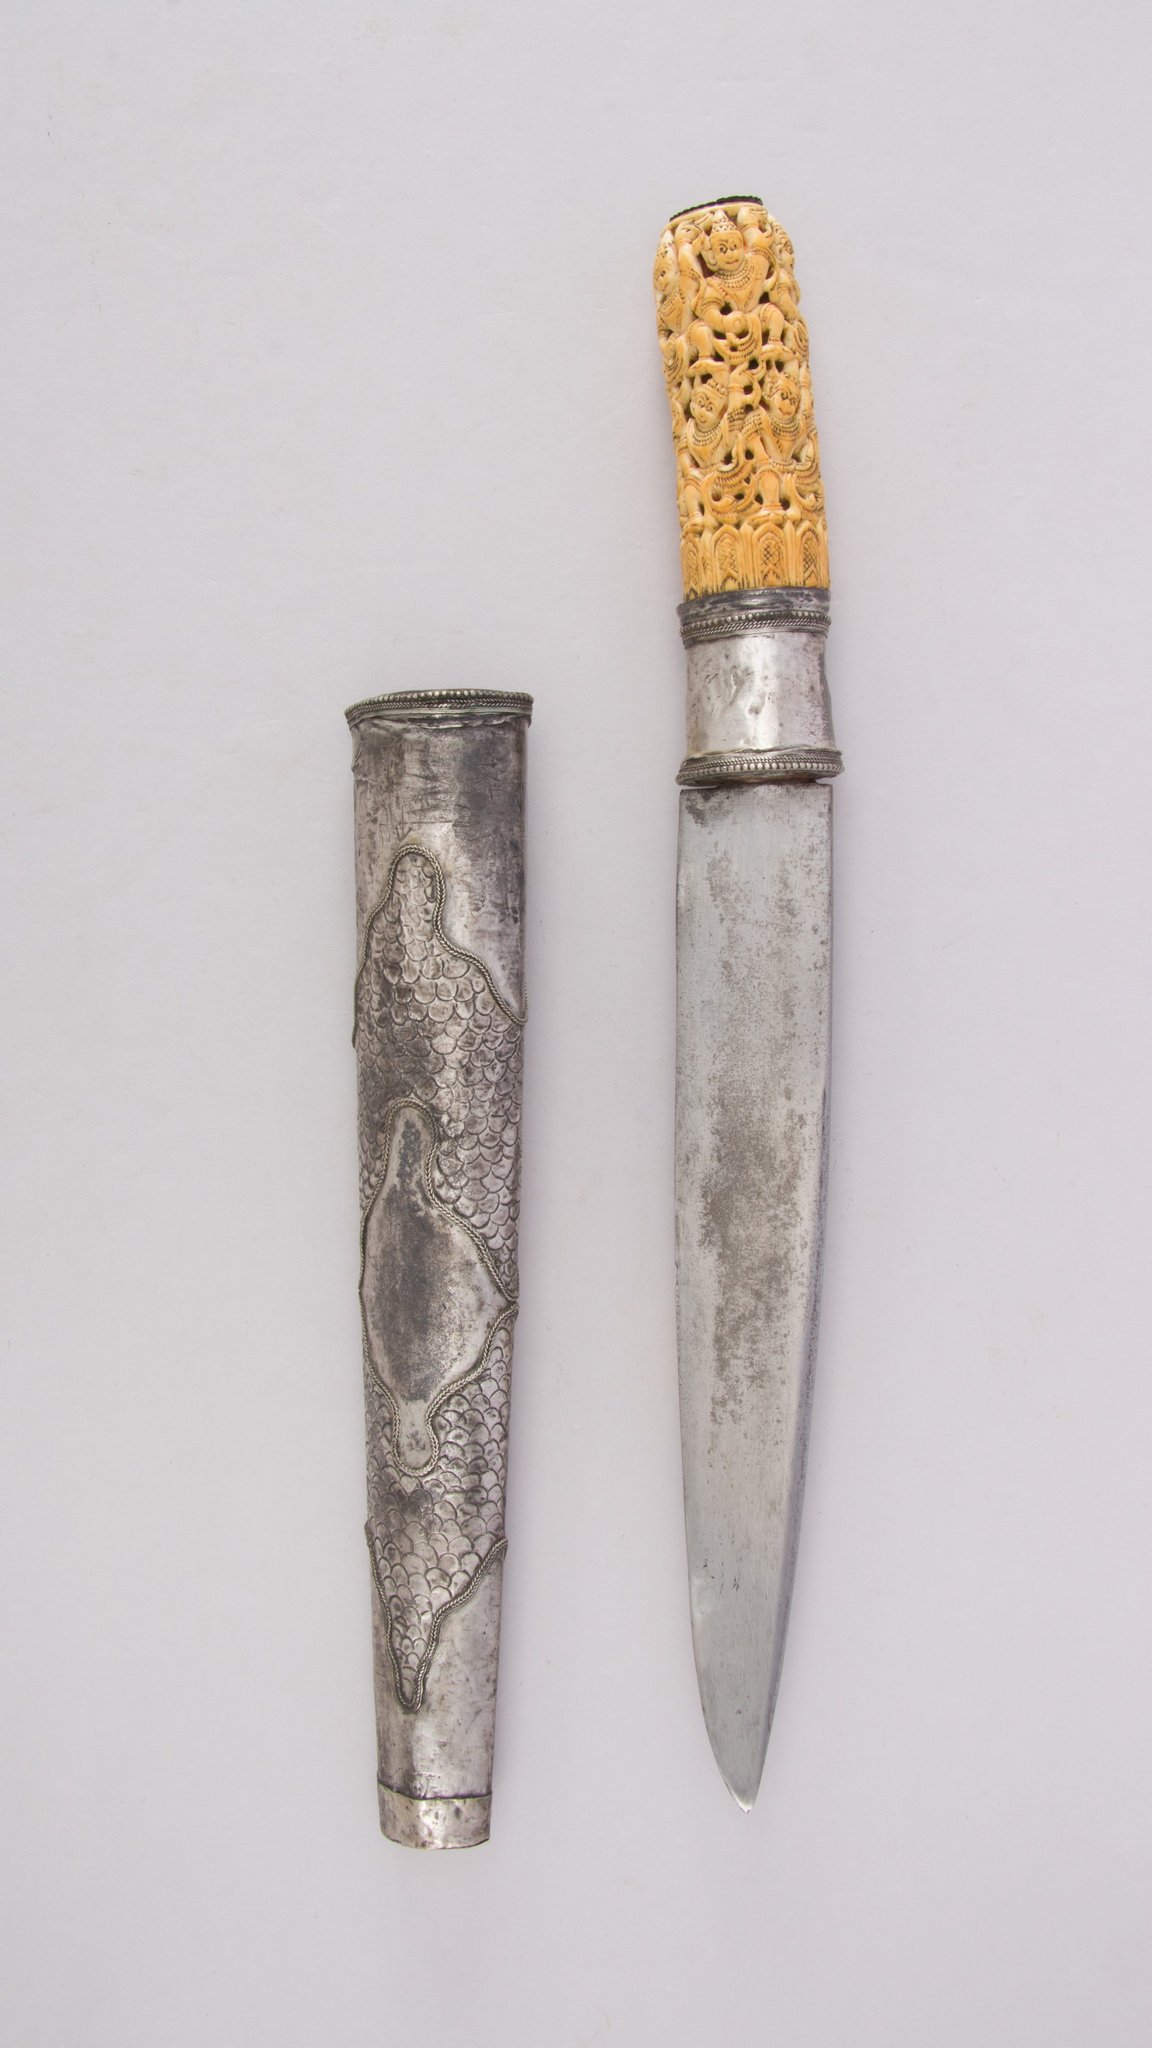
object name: dagger with sheath dah hmyaung or dha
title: Dagger with Sheath (Dah Hmyaung or Dha)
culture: burmese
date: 1701-1800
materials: ivory, silver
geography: myanmar